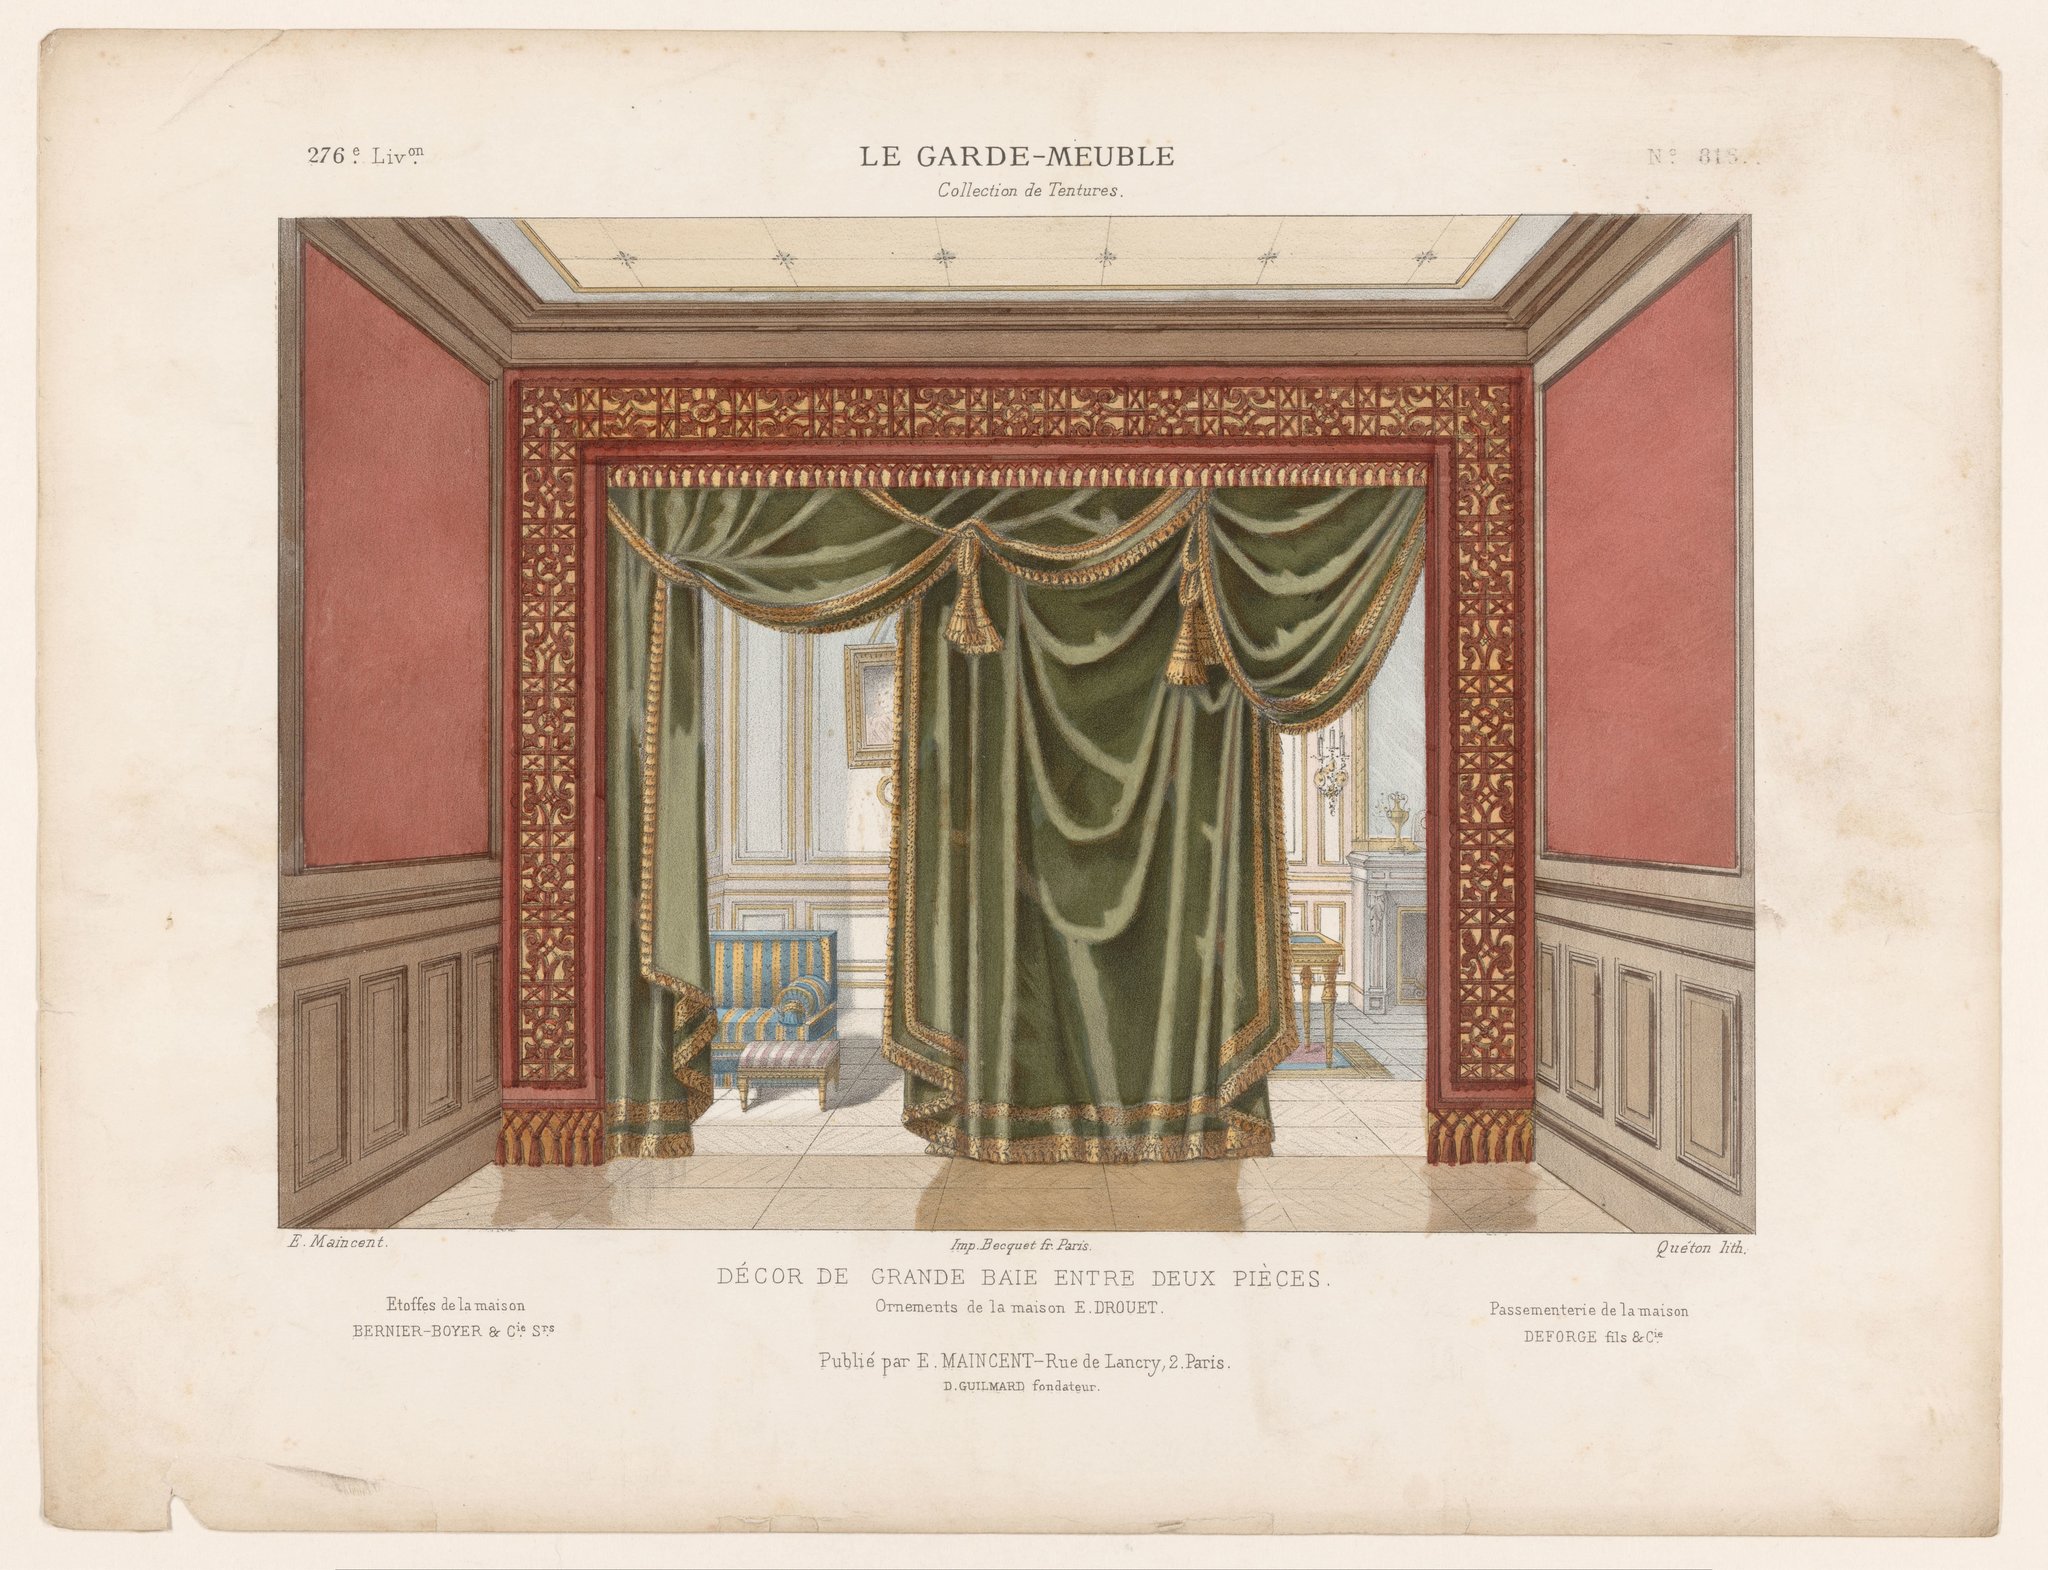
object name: print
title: Le Garde-Meuble / Collection de Tentures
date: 1885-1895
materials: paper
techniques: hand coloring, lithograph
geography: paris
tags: door, hangings and drapery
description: Grote doorgang met gedrapeerde gordijnen tussen twee vertrekken. Prent uit 276e Livraison.